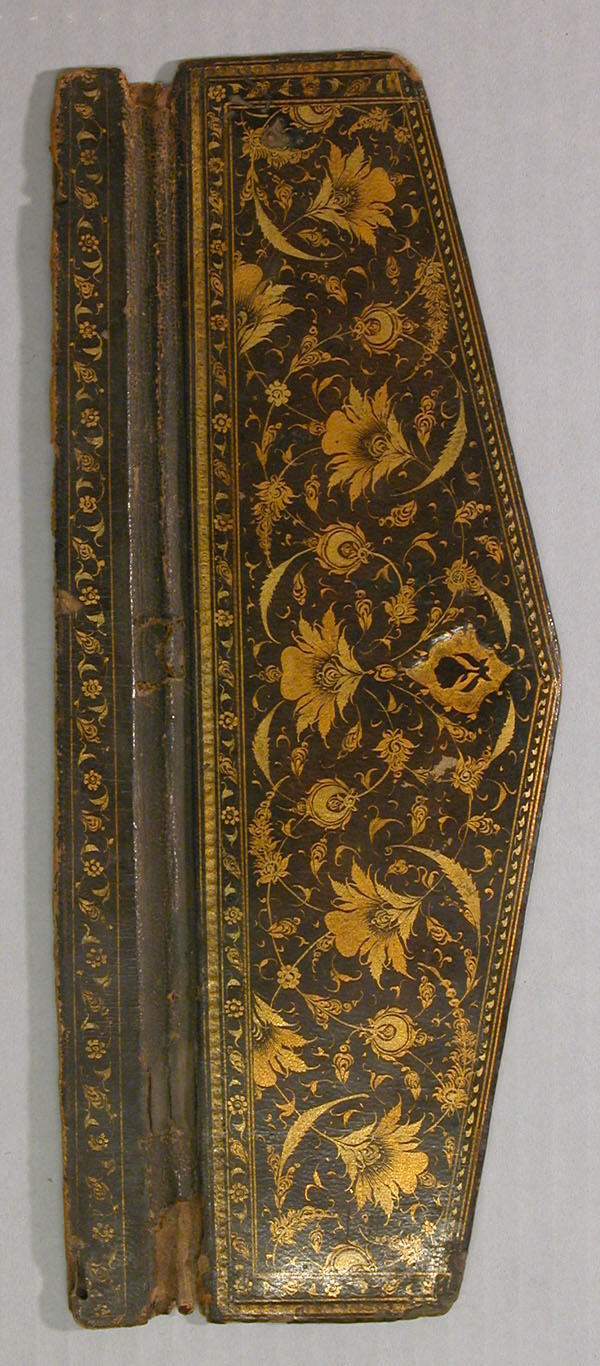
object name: flap of a bookbinding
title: Flap of a Bookbinding (Jild-i kitab)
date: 1601-1700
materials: leather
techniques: gilding, lacquer, painting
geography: iran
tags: flowers